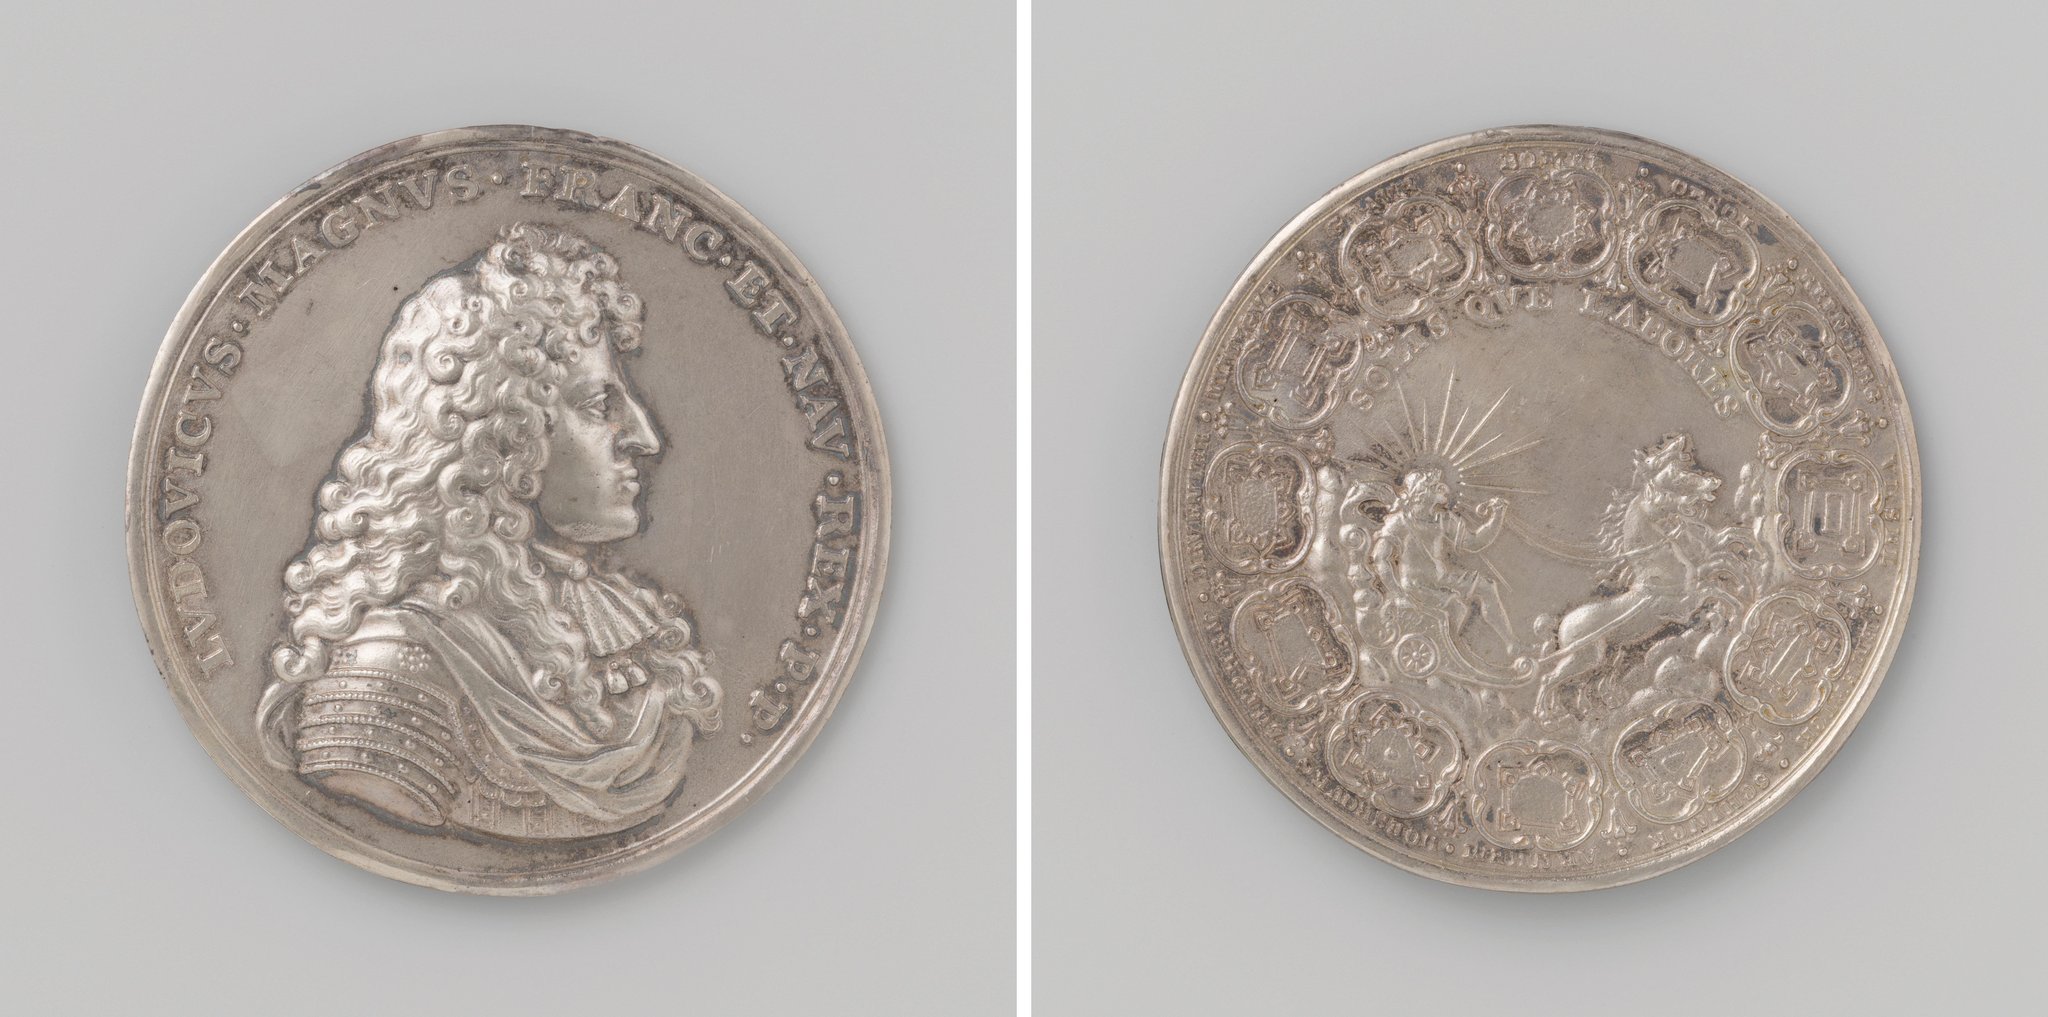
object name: history medal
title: Lodewijk XIV verovert twaalf steden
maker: Anonymous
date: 1672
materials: silver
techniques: striking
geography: france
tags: lodewijk xiv (koning van frankrijk), deventer, nijmegen, grave, arnhem, rampjaar (disaster year)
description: Medal with portrait of Louis XIV. The medal was struck to mark the capture of 40 cities in 22 days by Louis XIV.